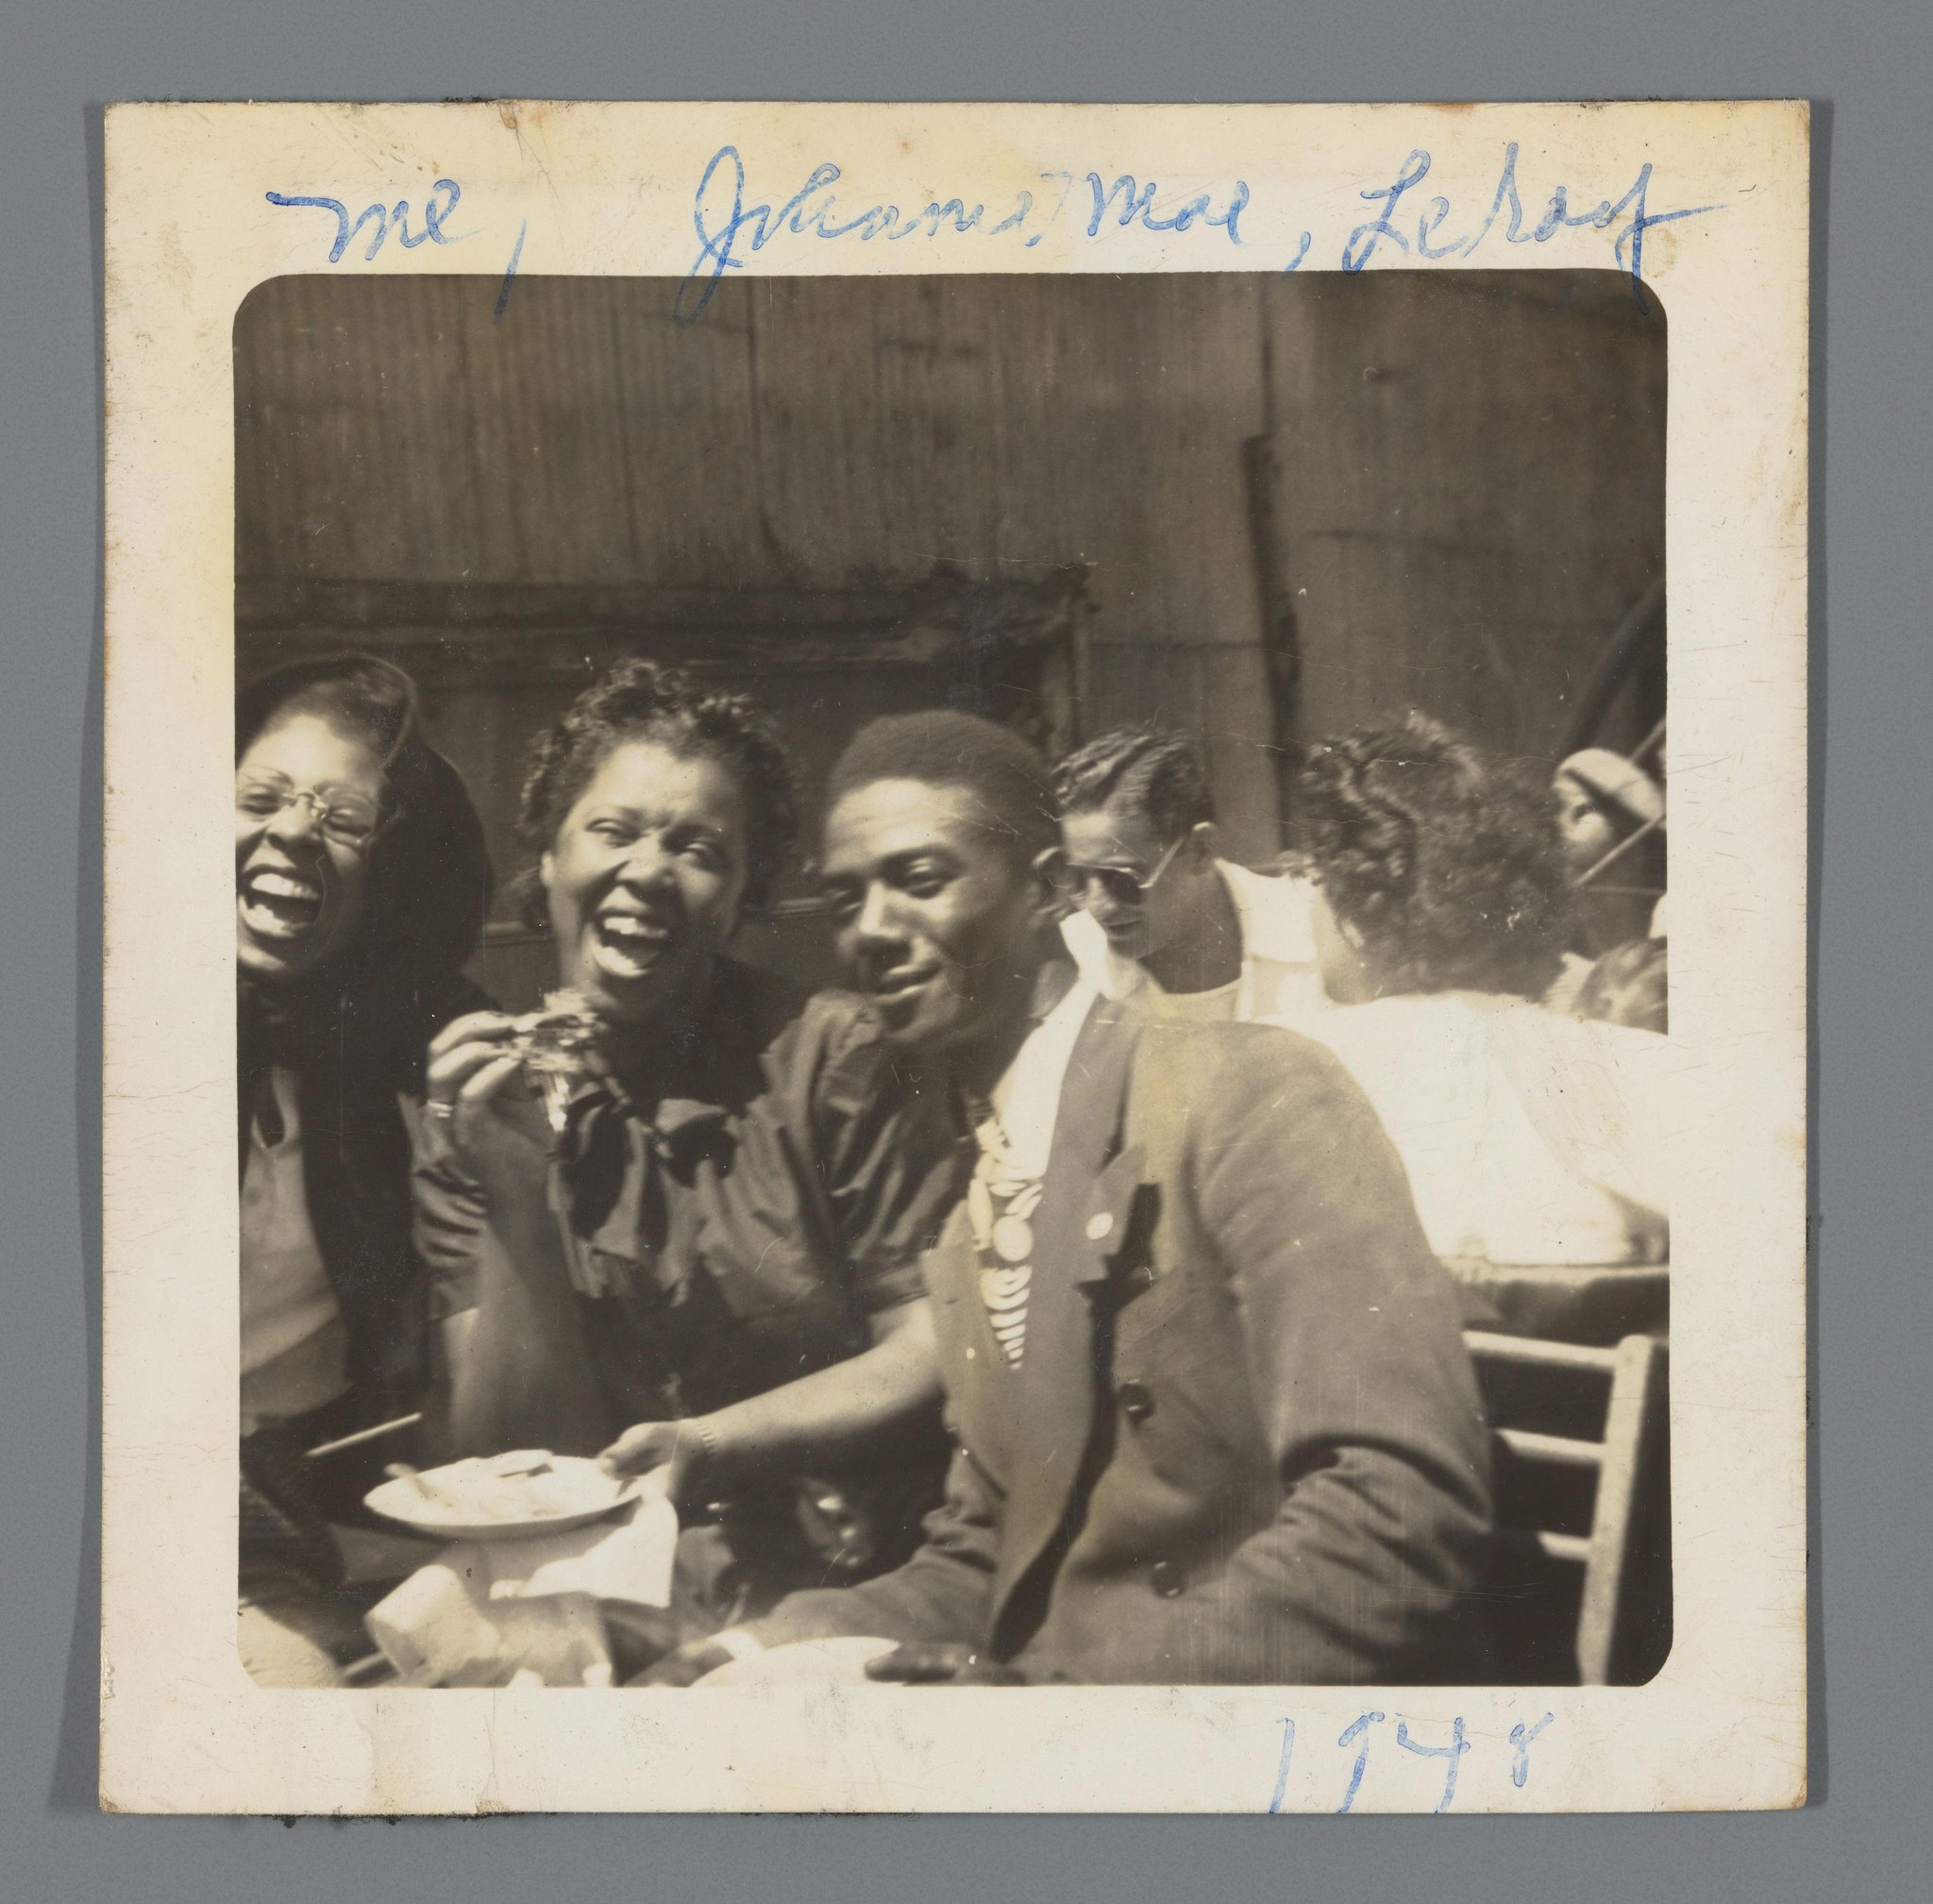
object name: photograph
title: Twee vrouwen en een man aan een terrastafel zittend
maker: Anonymous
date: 1948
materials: paper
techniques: gelatin silver print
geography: united states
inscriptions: inscription: ‘Me, Johanna [?], Leroy’, inscription: ‘1948’